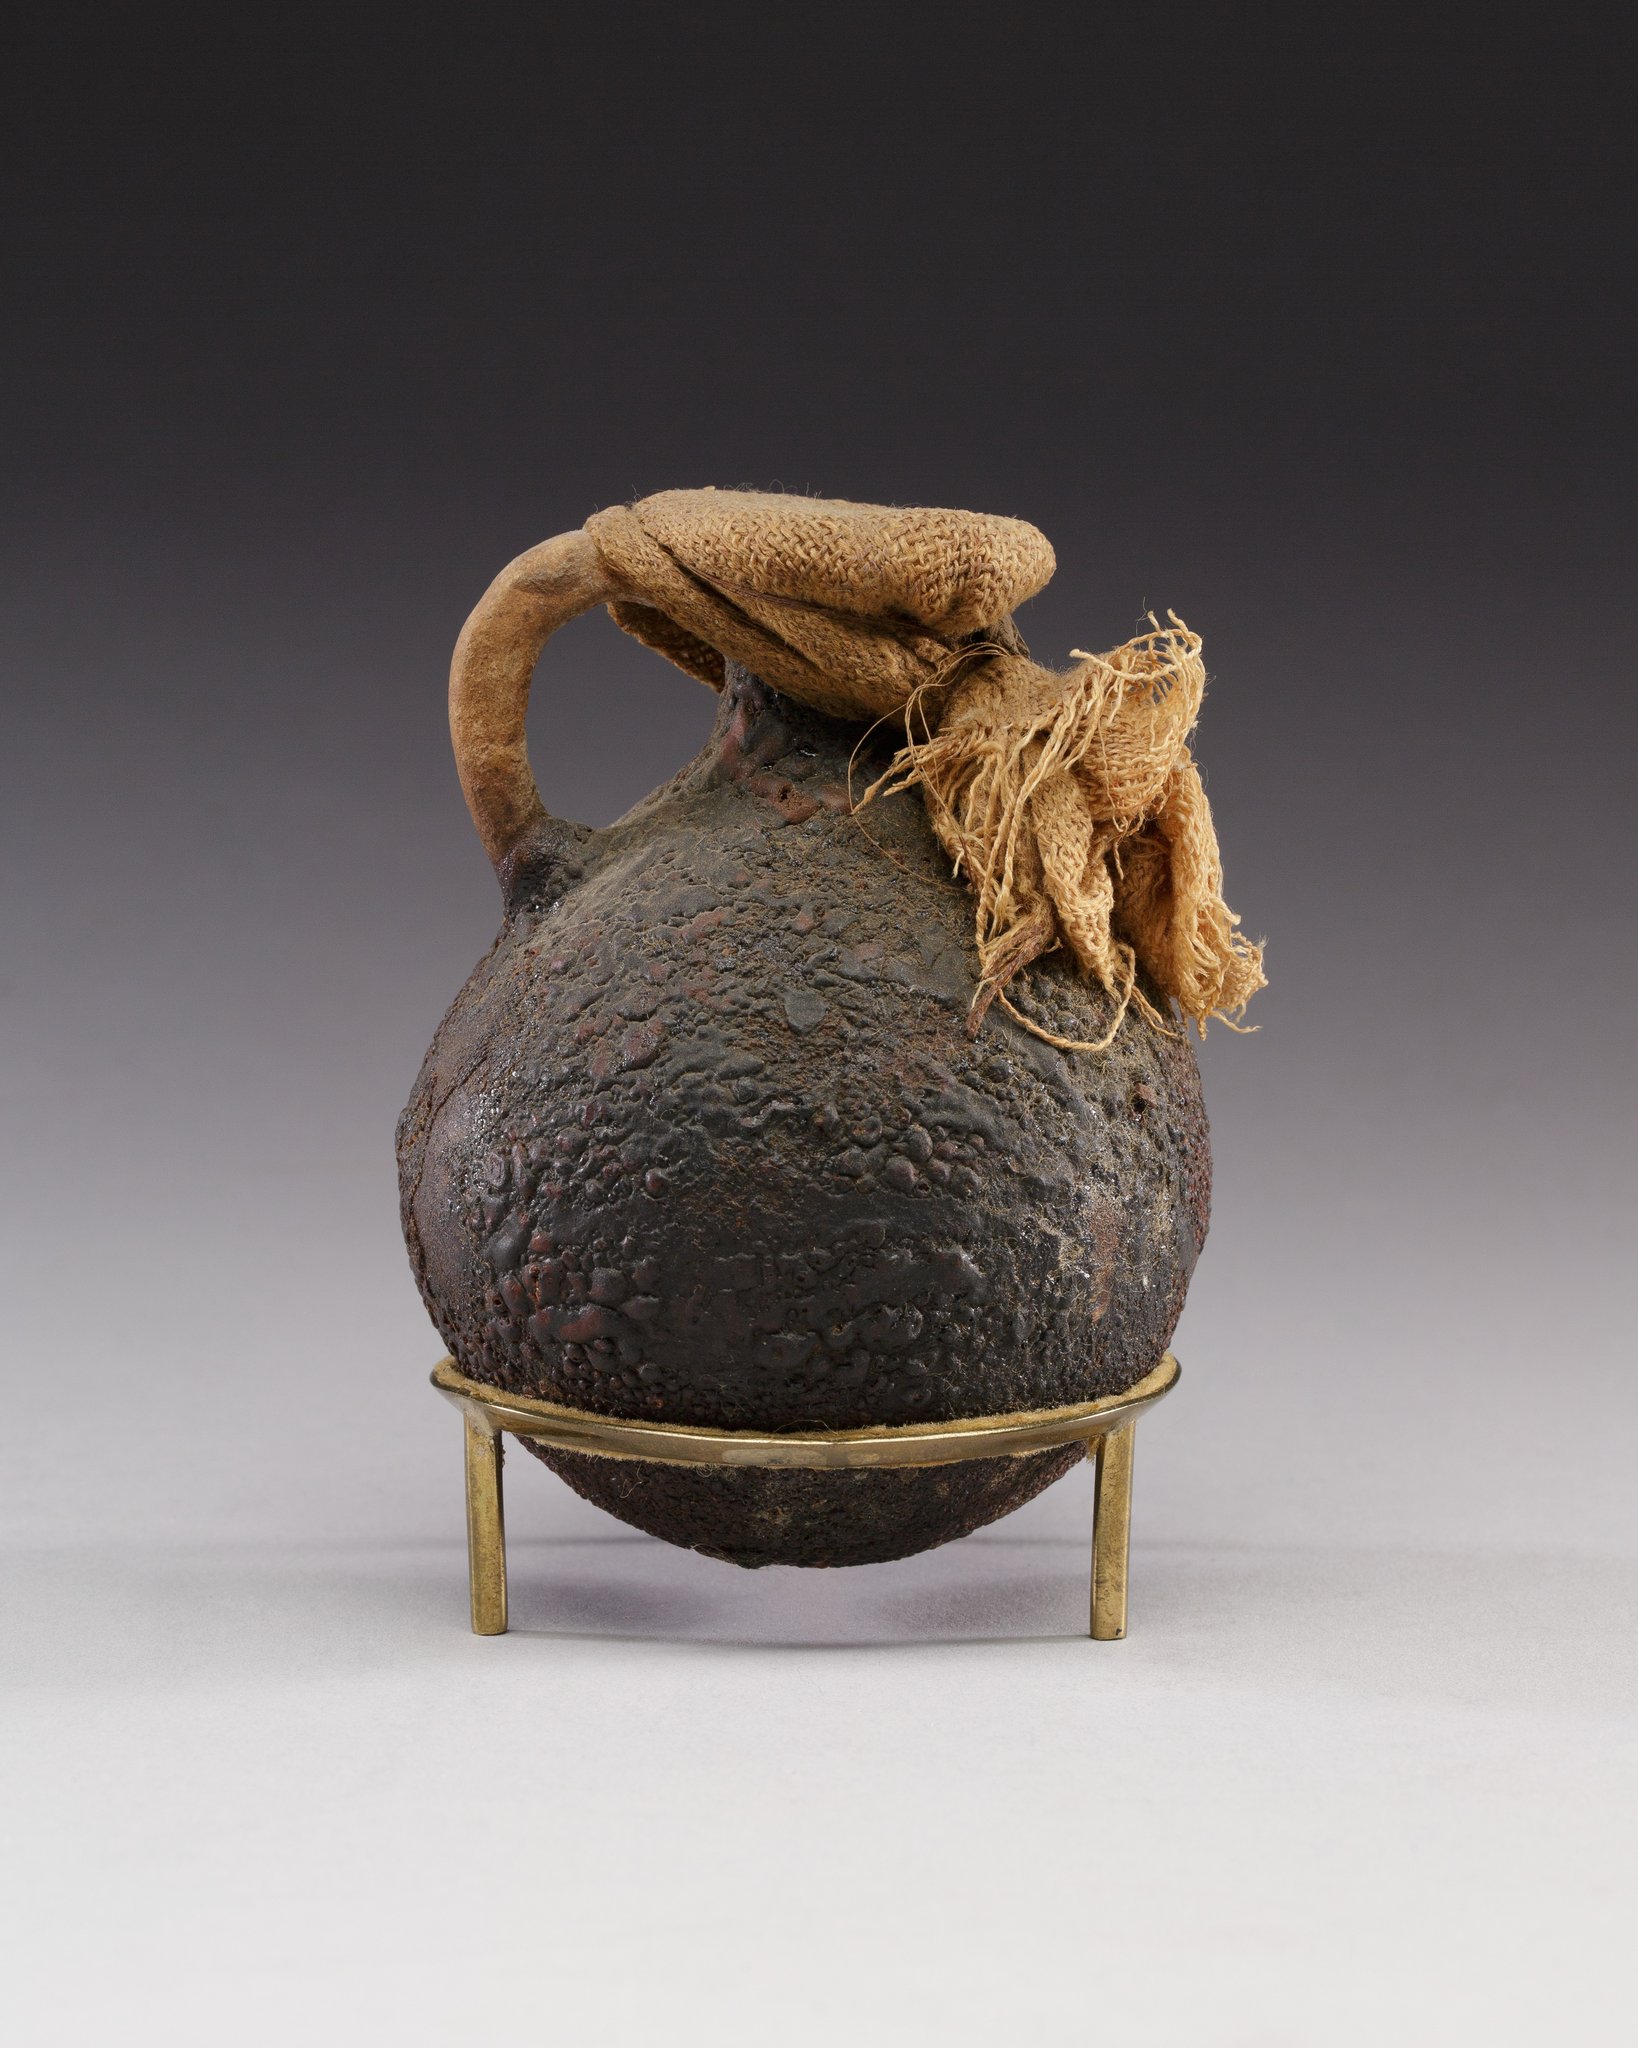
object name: juglet, mud sealing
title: Small Jug sealed with Cloth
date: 1492-1473 BCE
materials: linen, mud, pottery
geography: egypt